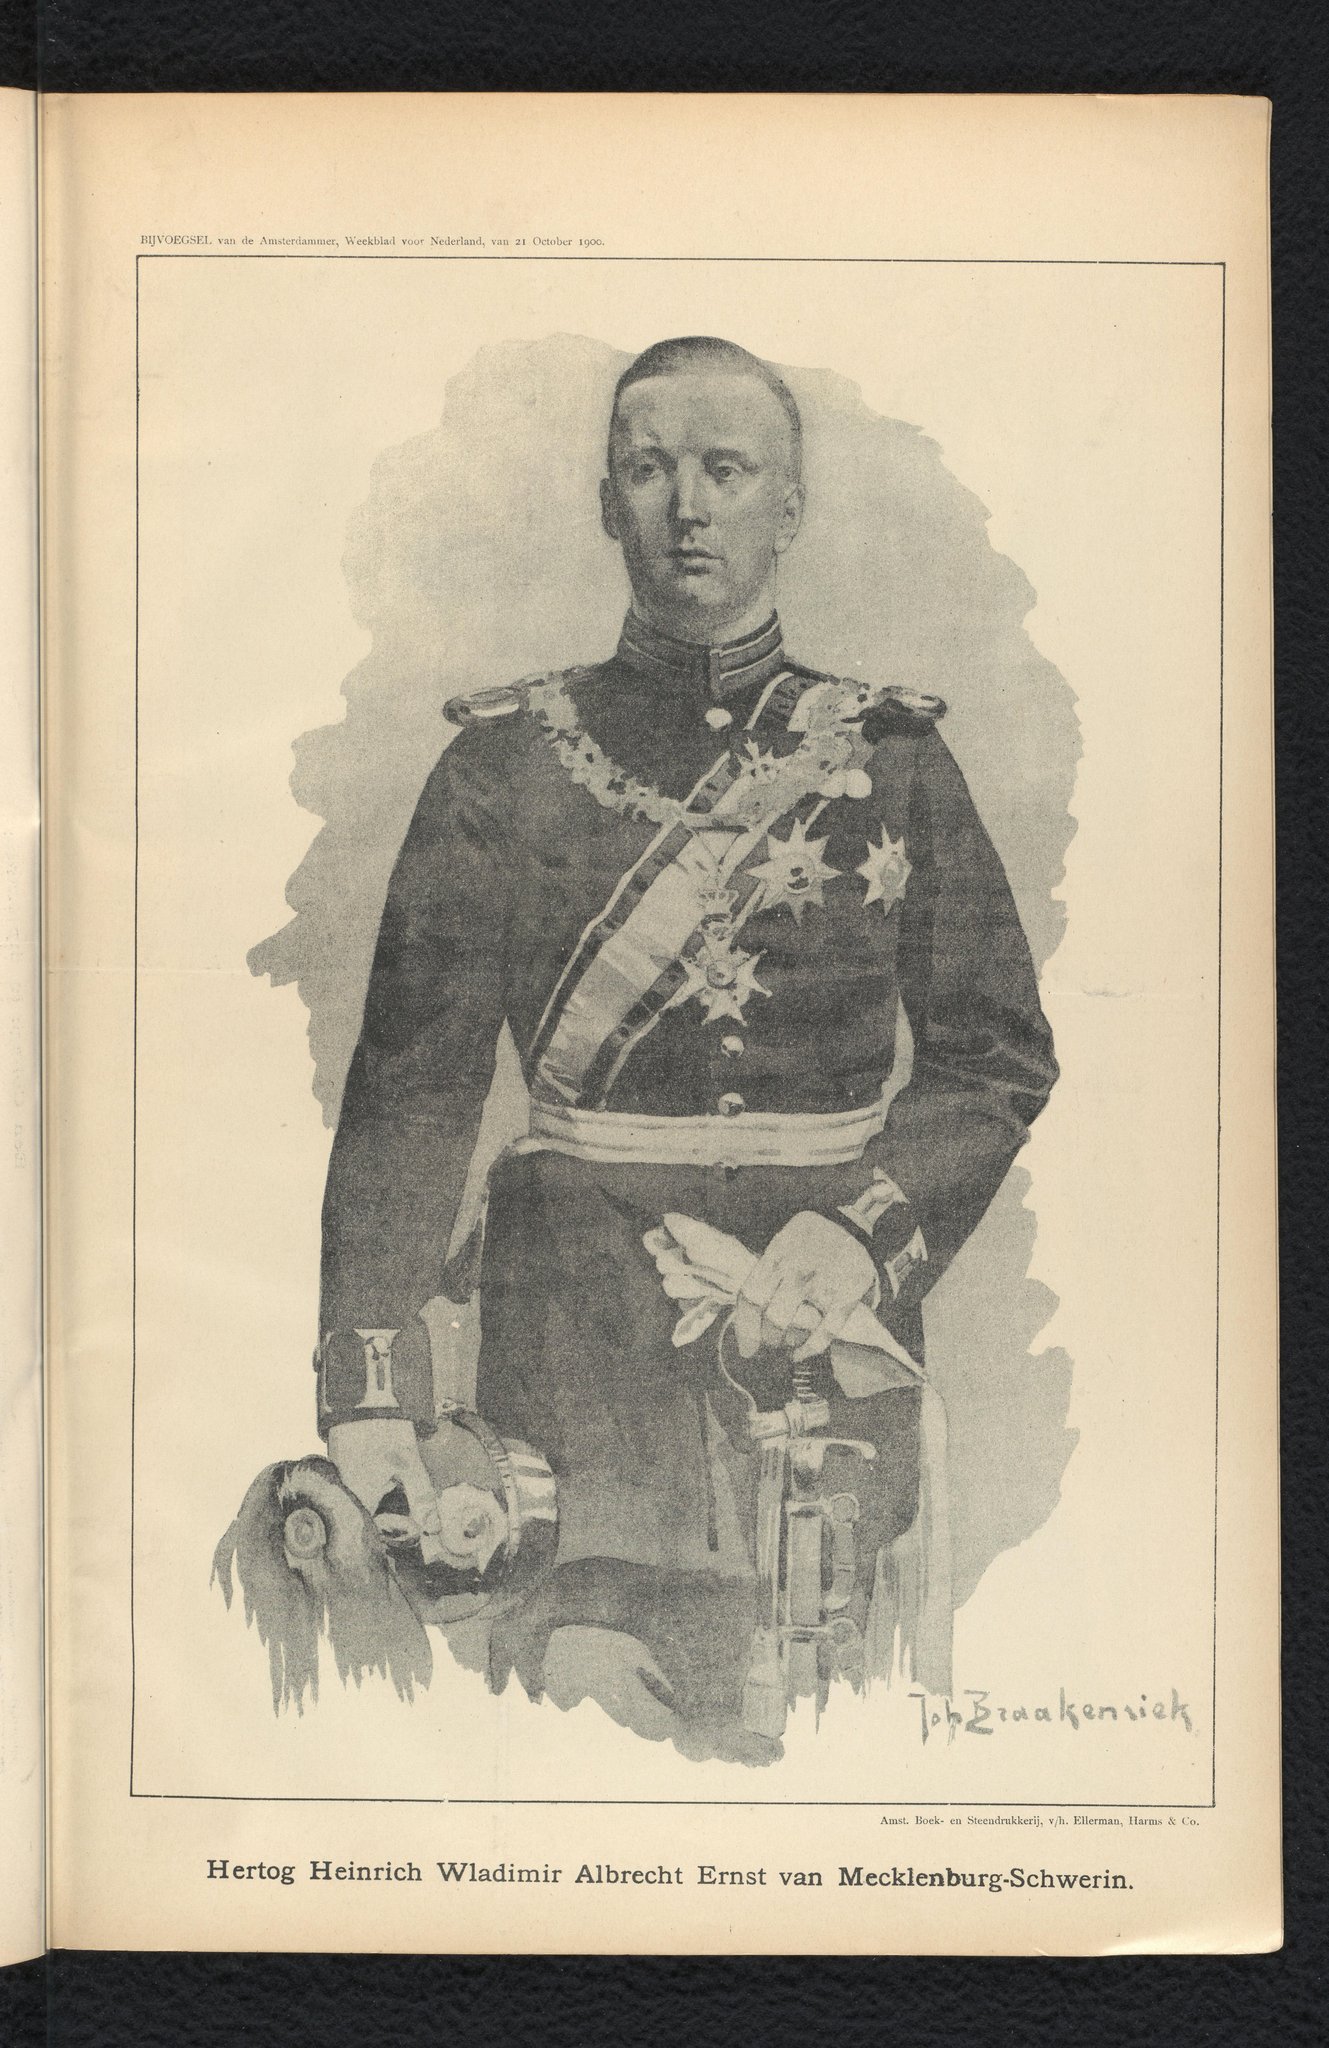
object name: print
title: Hertog Heinrich Wladimir Albrecht Ernst van Mecklenburg-Schwerin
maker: johan braakensiek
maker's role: draughtsman, print maker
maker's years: 1858-1940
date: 1900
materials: paper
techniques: lithograph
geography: amsterdam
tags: the hague, hendrik (prins der nederlanden (1876-1934)), historical persons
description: Portret van prins Hendrik van Mecklenburg-Schwerin, verloofde van koningin Wilhelmina.